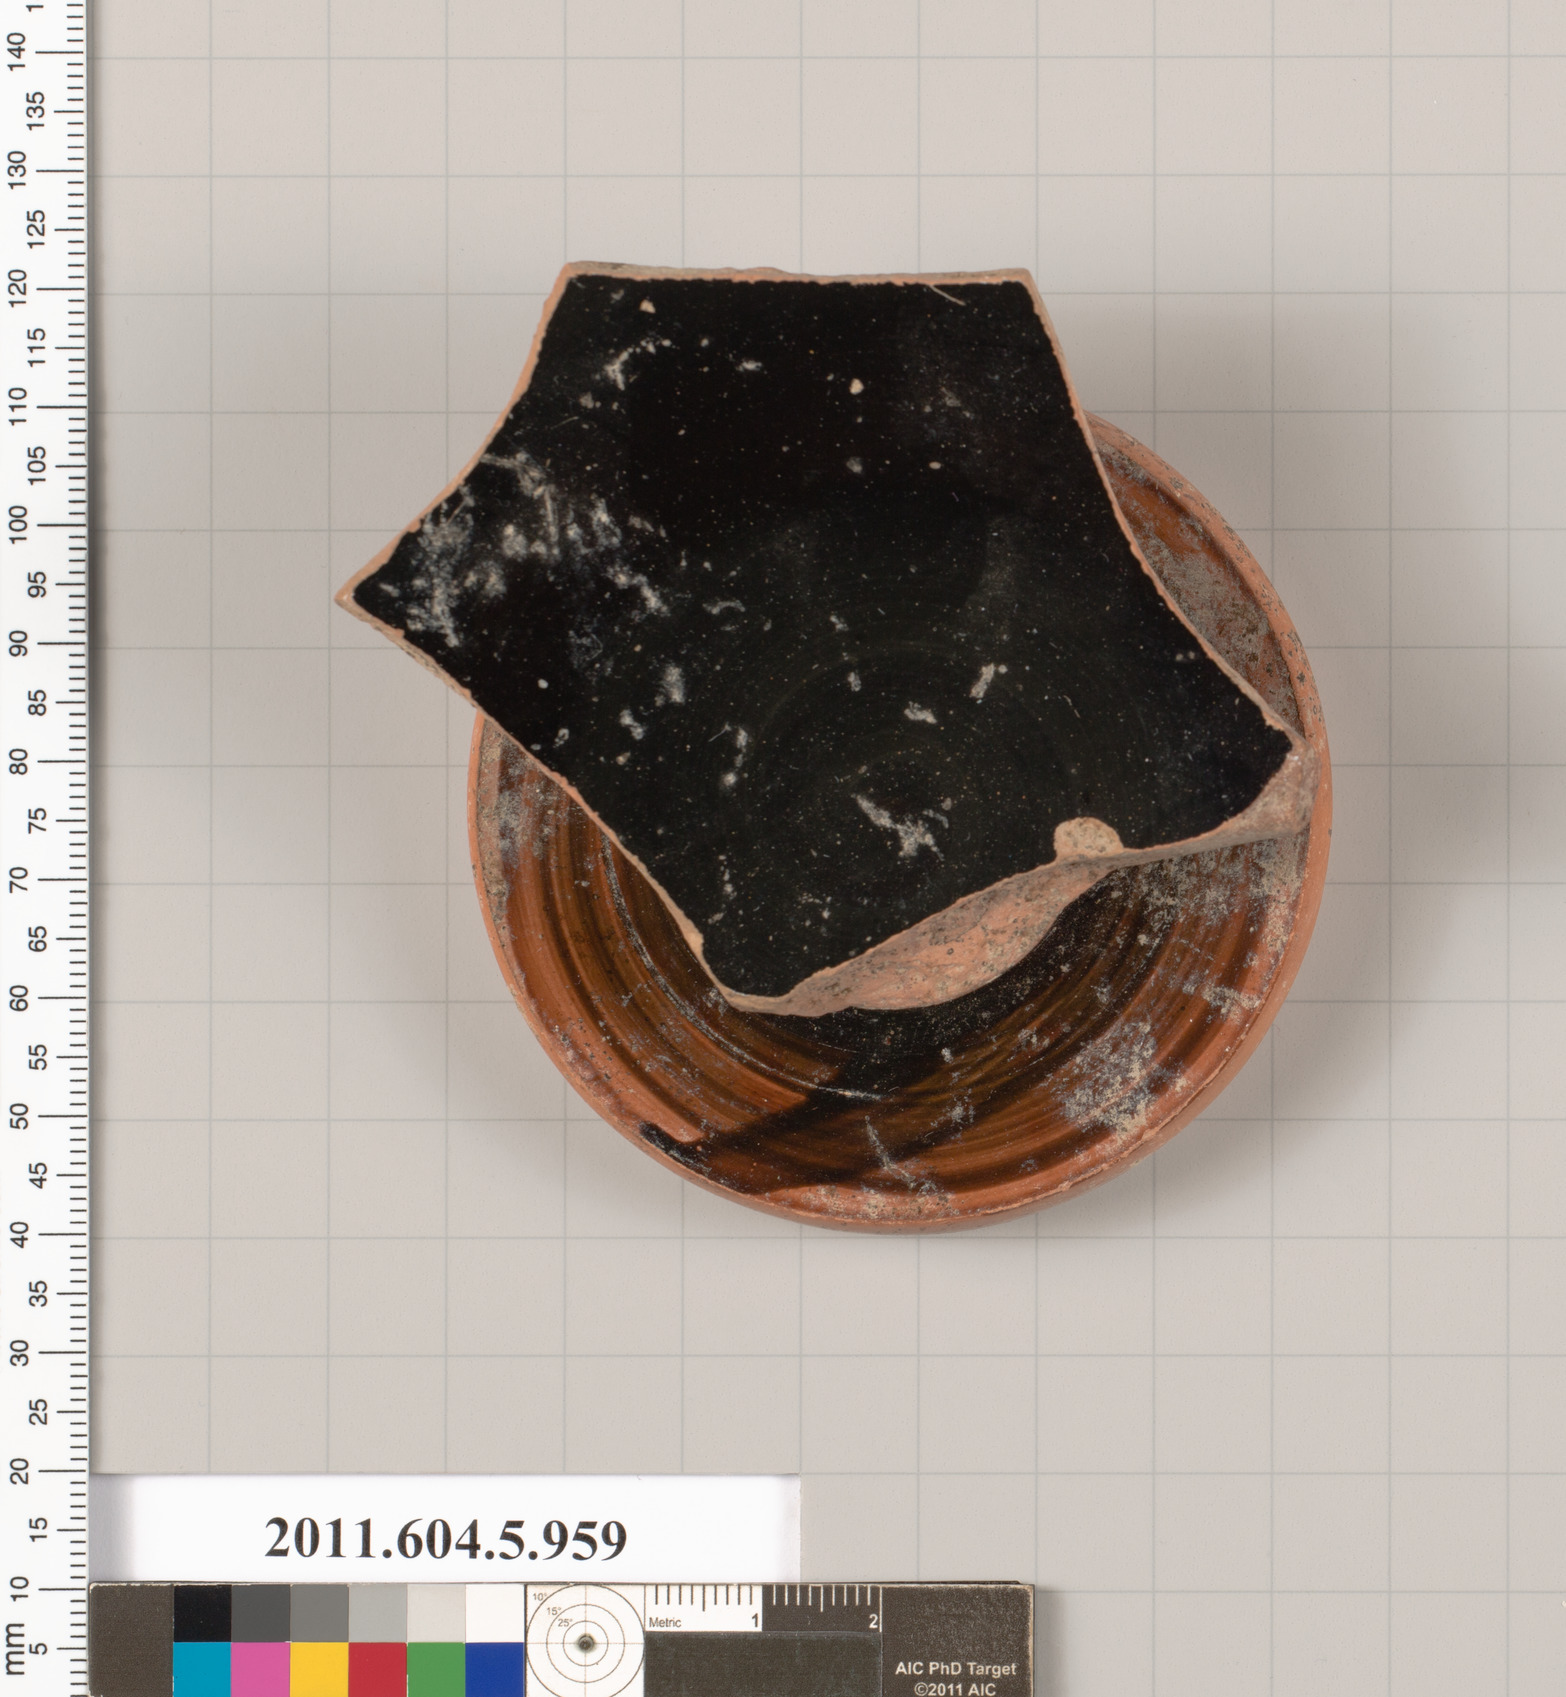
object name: kylix fragment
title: Terracotta fragment of a kylix (drinking cup)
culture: greek, attic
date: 600-401 BCE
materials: terracotta